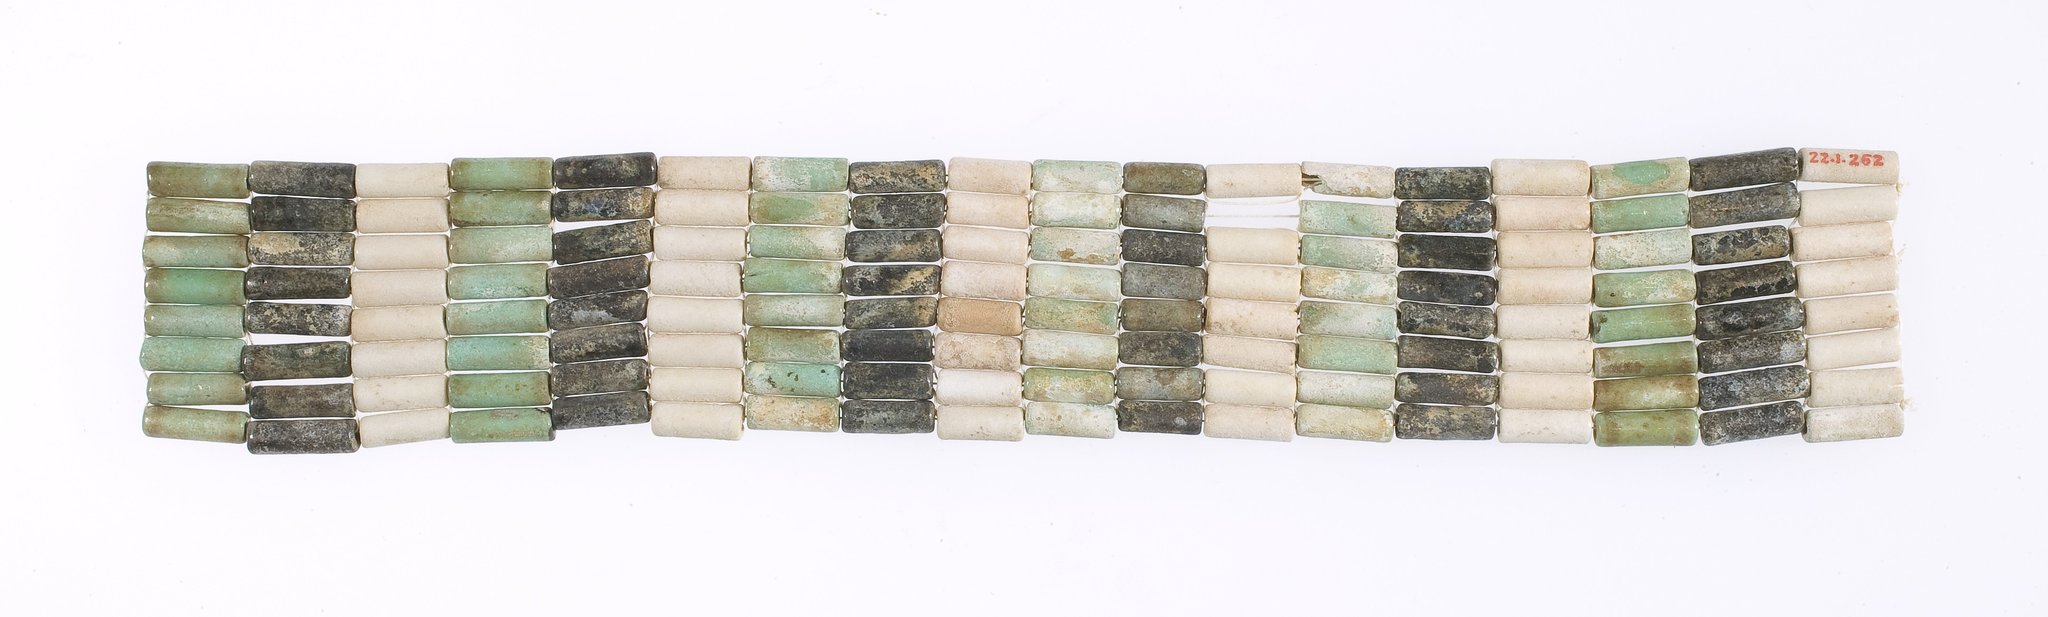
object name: anklet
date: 1802-1700 BCE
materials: faience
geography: egypt